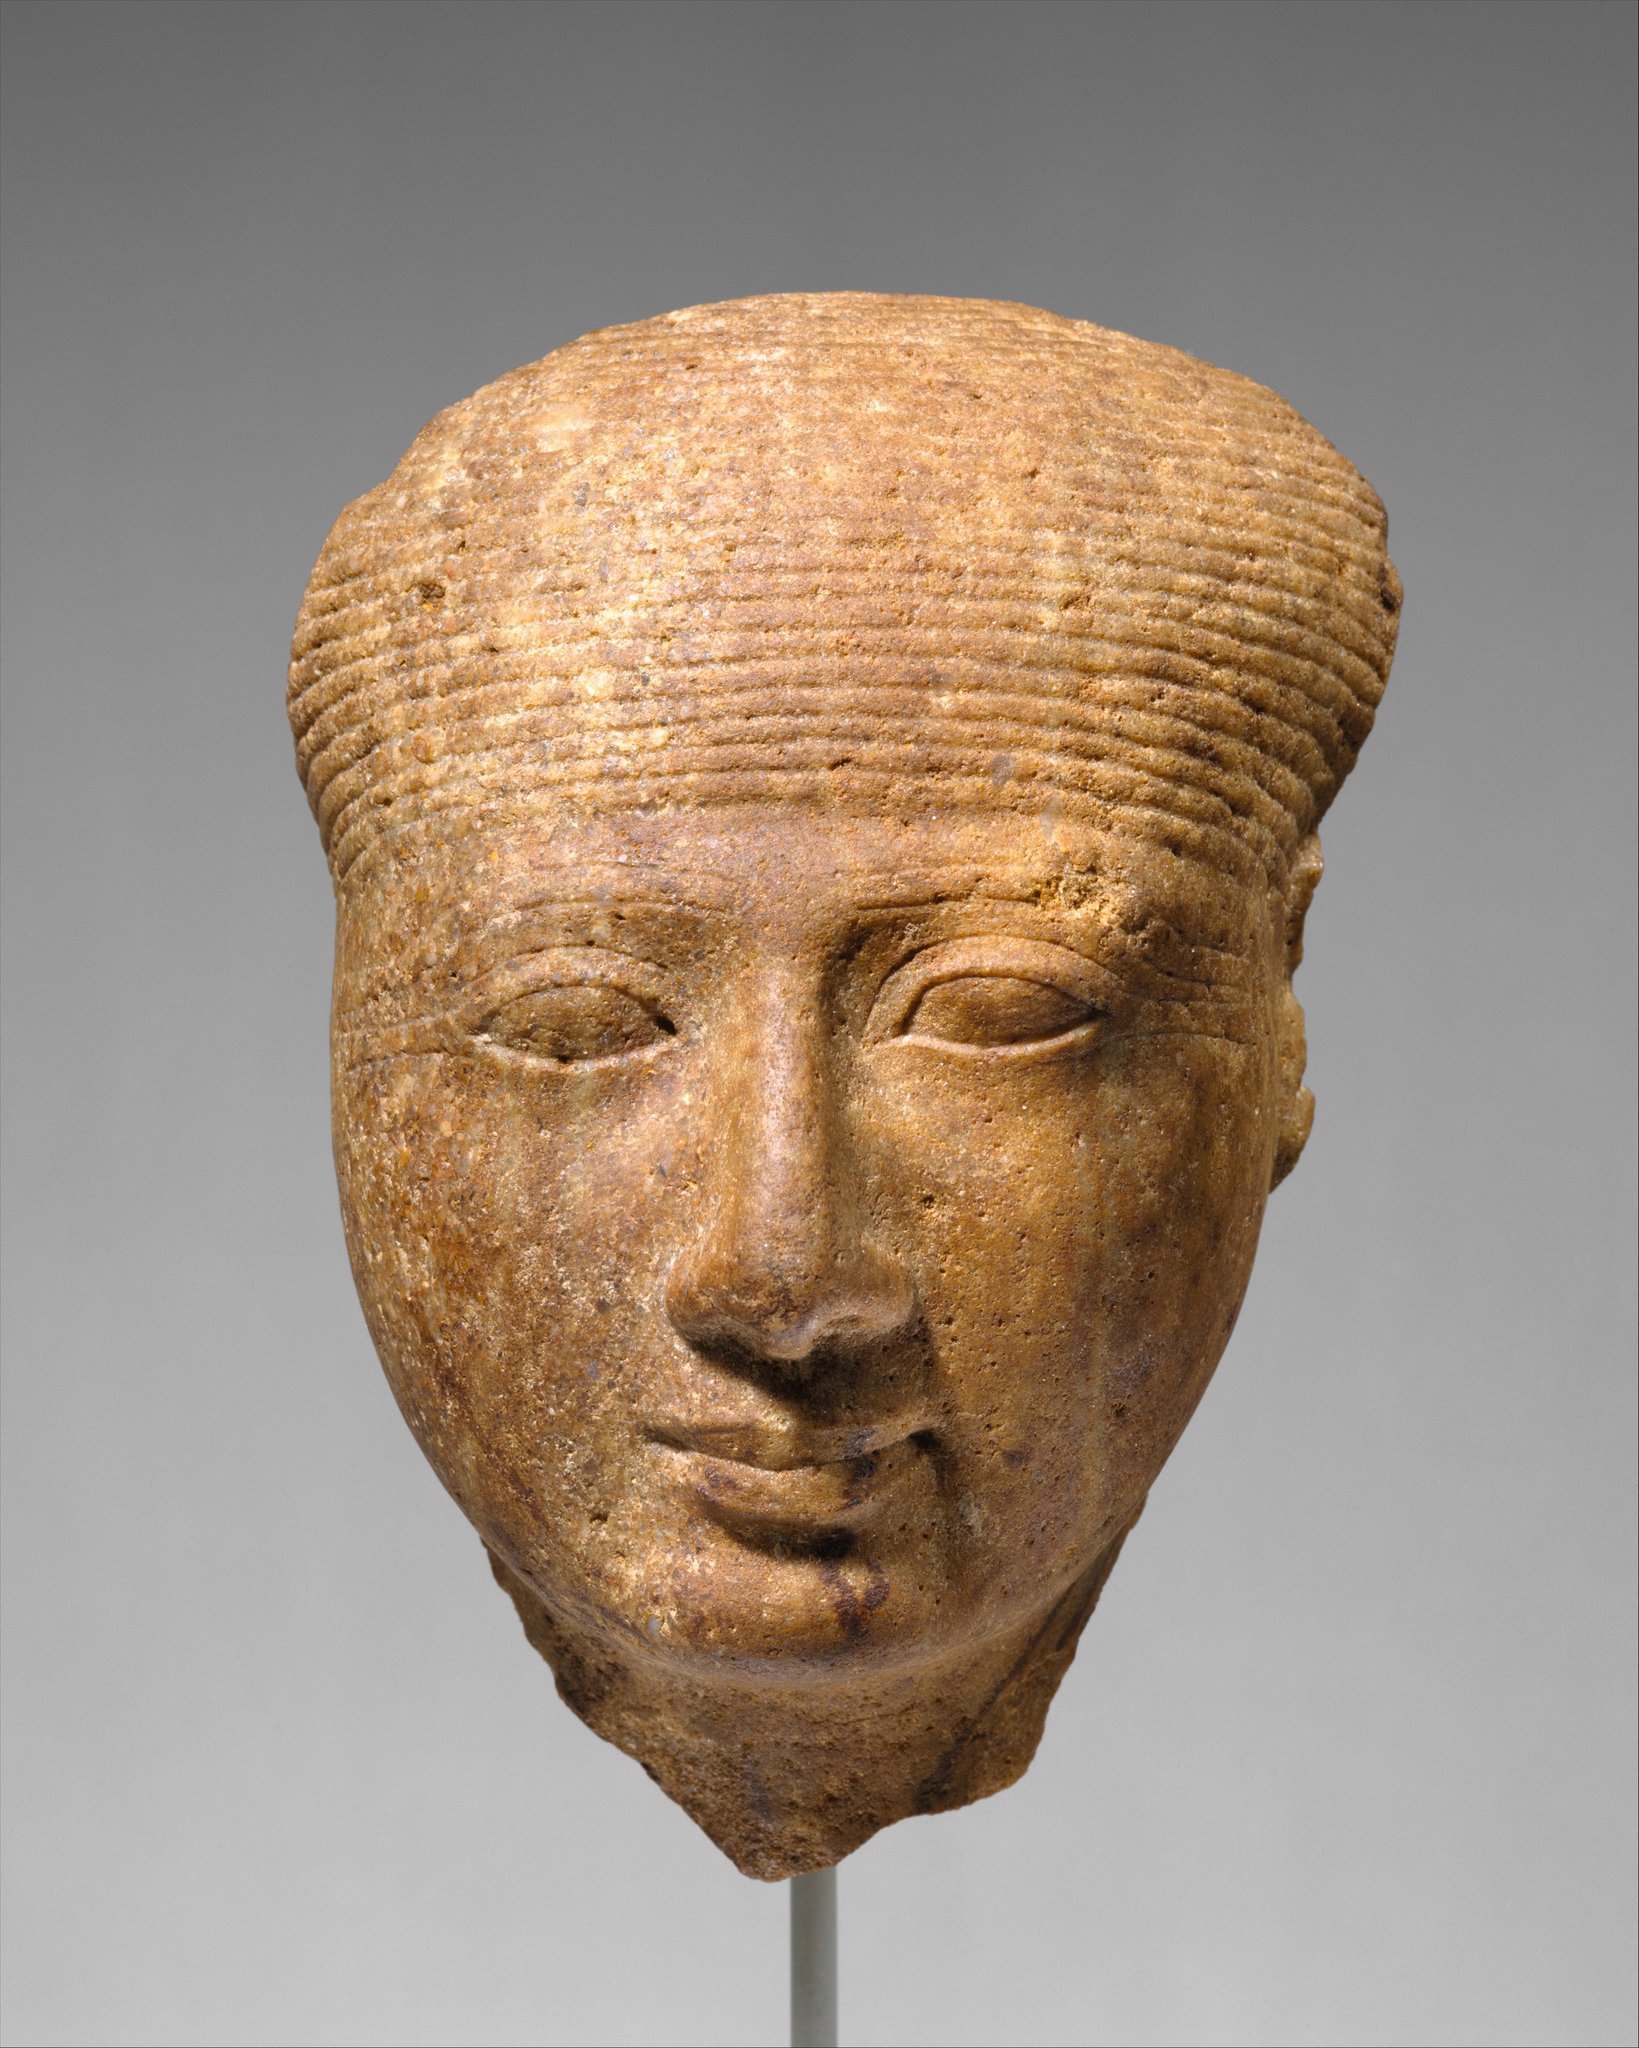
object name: head, goddess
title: Head of a goddess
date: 1295-1270 BCE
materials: quartzite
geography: egypt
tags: heads